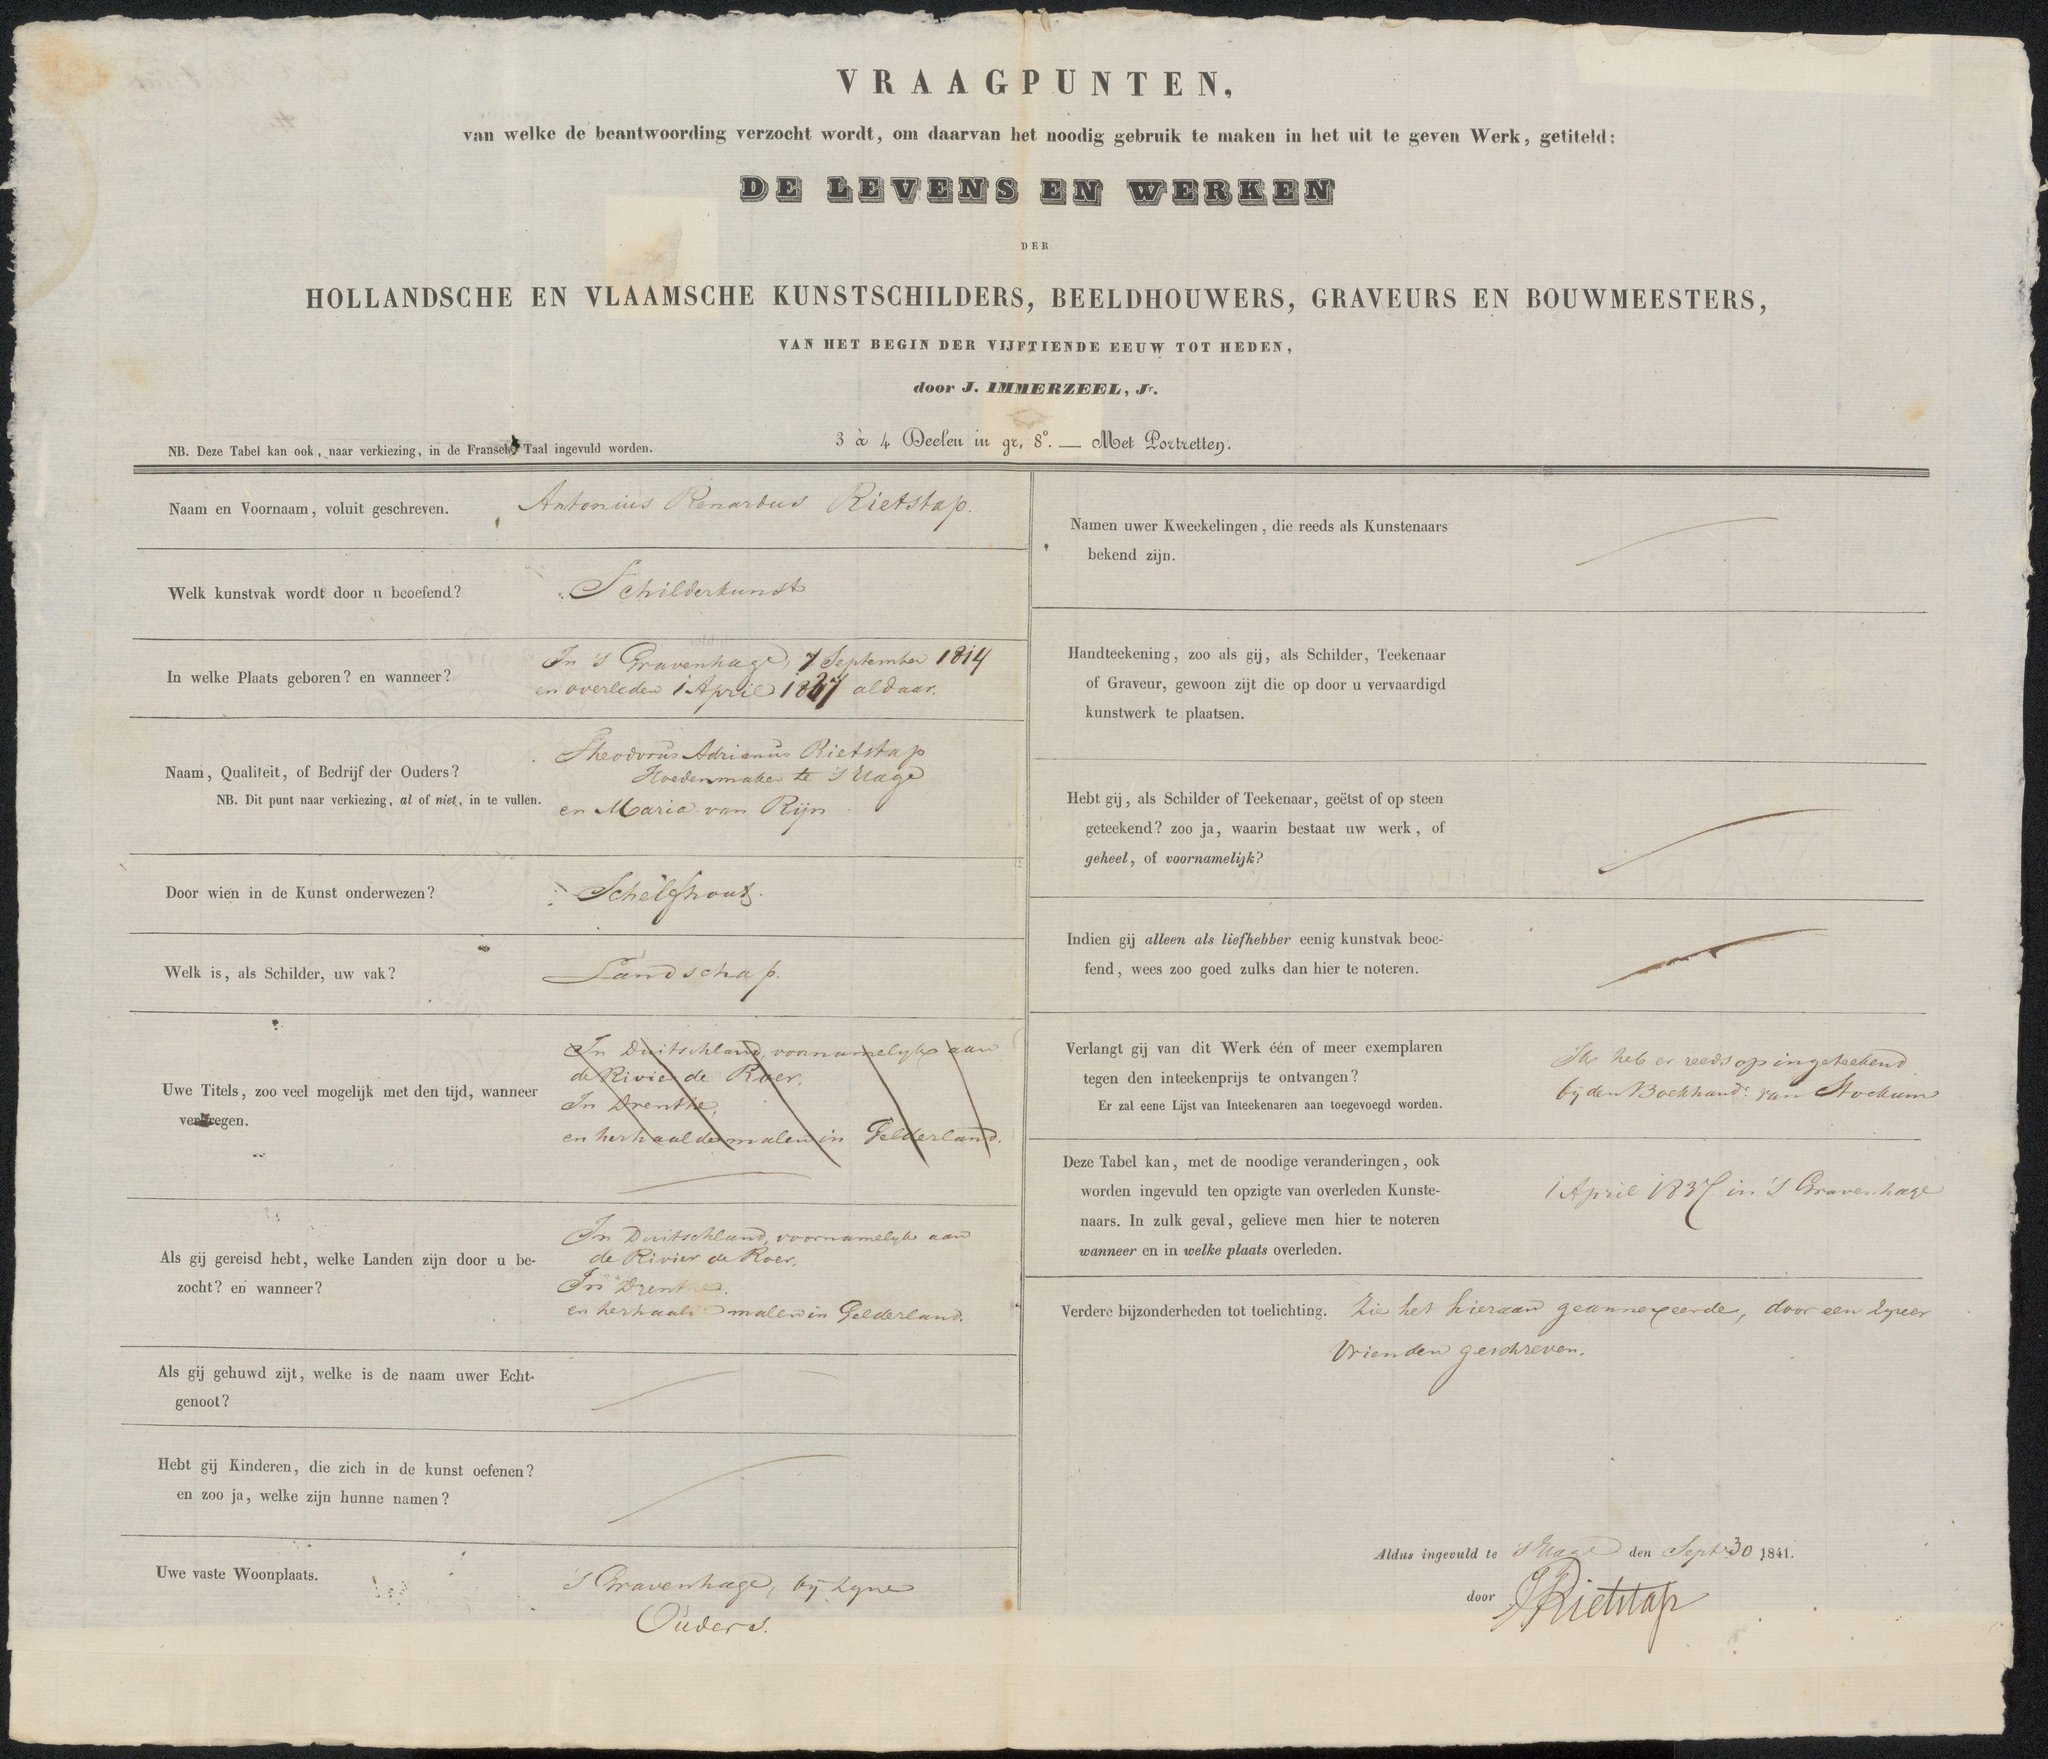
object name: questionnaire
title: Enquêteformulier betreffende Antonius Renardus Rietstap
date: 1841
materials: ink, paper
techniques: pen, printing, writing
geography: the hague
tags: the hague, antonius renardus rietstap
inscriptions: watermark, inscription: ‘Vraagpunten,/ van welke de beantwoording verzocht wordt, om daarvan het noodig gebruik te maken in het uit te geven Werk, getiteld: De levens en werken/ der Hollandsche en Vlaamsche kunstschilders, beeldhouwers,/ graveurs en bouwmeesters, van het begin der vijftiende eeuw tot heden/ door J. Immerzeel, Jr.’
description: Opgenomen in: Immerzeel, J. Jr., De levens en werken der Hollandsche en Vlaamsche kunstschilders, beeldhouwers, graveurs en bouwmeesters, van het begin der vijftiende eeuw tot heden, Amsterdam: J.C. van Kesteren, 1842-1843.